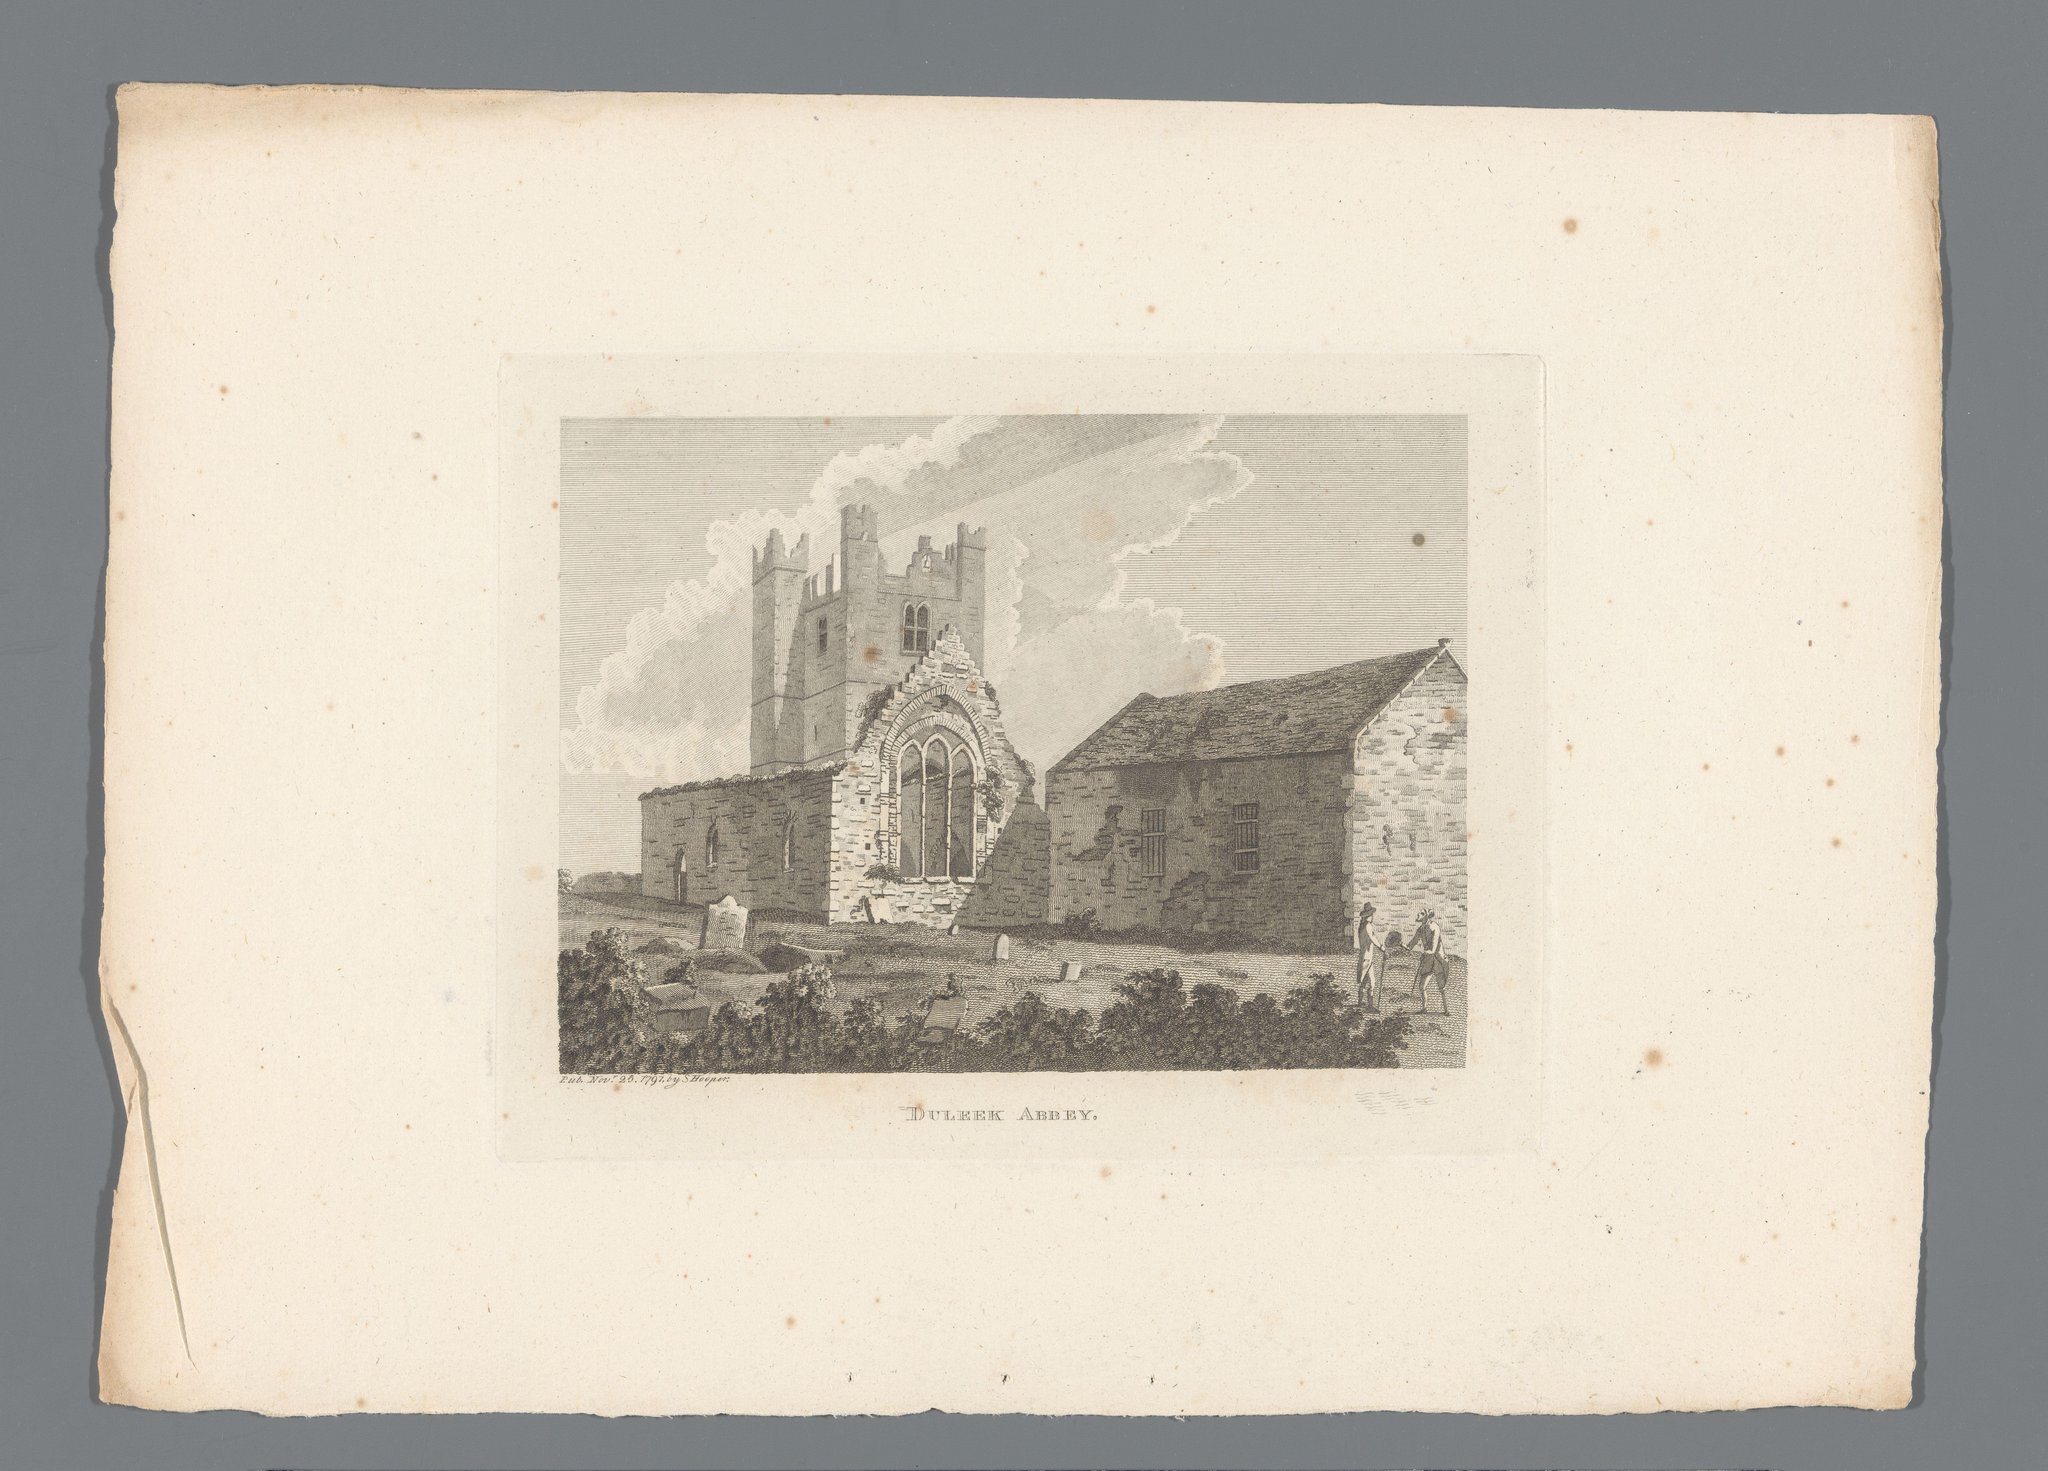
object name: print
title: Duleek Abbey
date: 1791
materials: paper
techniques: etching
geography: london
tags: abbey, monastery, convent ~ roman catholic church, landscape with ruins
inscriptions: date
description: Prent verschenen in: Grose, Francis. The antiquities of Ireland. Londen: S. Hooper, 1795, dl. 2.